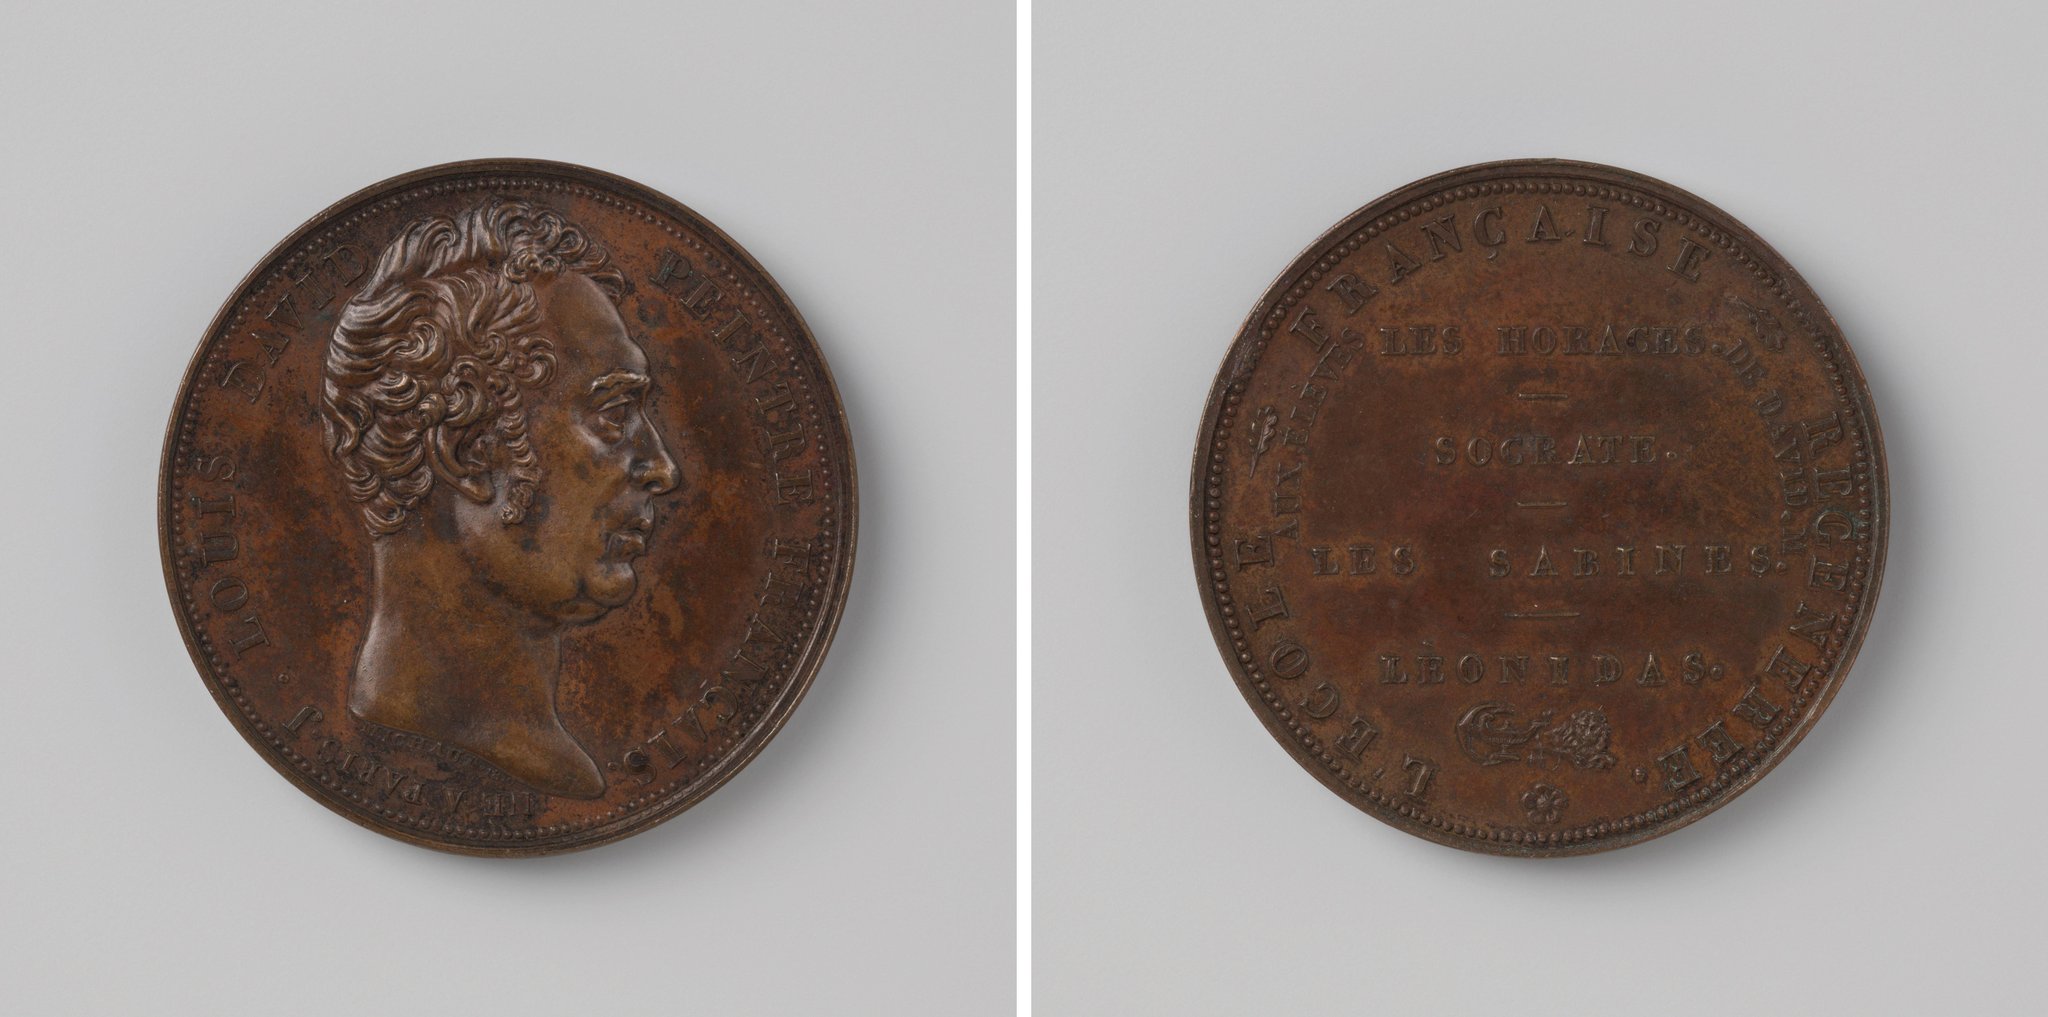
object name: history medal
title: Jacques Louis David, Frans schilder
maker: auguste francois michaut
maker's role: sculptor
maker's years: 1786-1879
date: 1819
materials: bronze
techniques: striking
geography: netherlands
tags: paris, brussels, painter, draughtsman, jacques-louis david, france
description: Bronzen penning. Voorzijde: borststuk man binnen omschrift. Keerzijde: opschrift boven anker, brandende olielamp en liggende leeuw binnen binnen omschrift